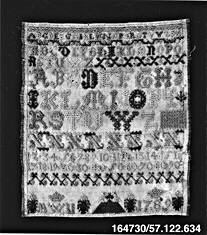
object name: sampler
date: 1789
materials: canvas, silk, wool